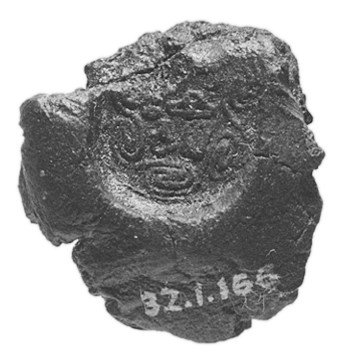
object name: sealing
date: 2030-1640 BCE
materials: clay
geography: egypt